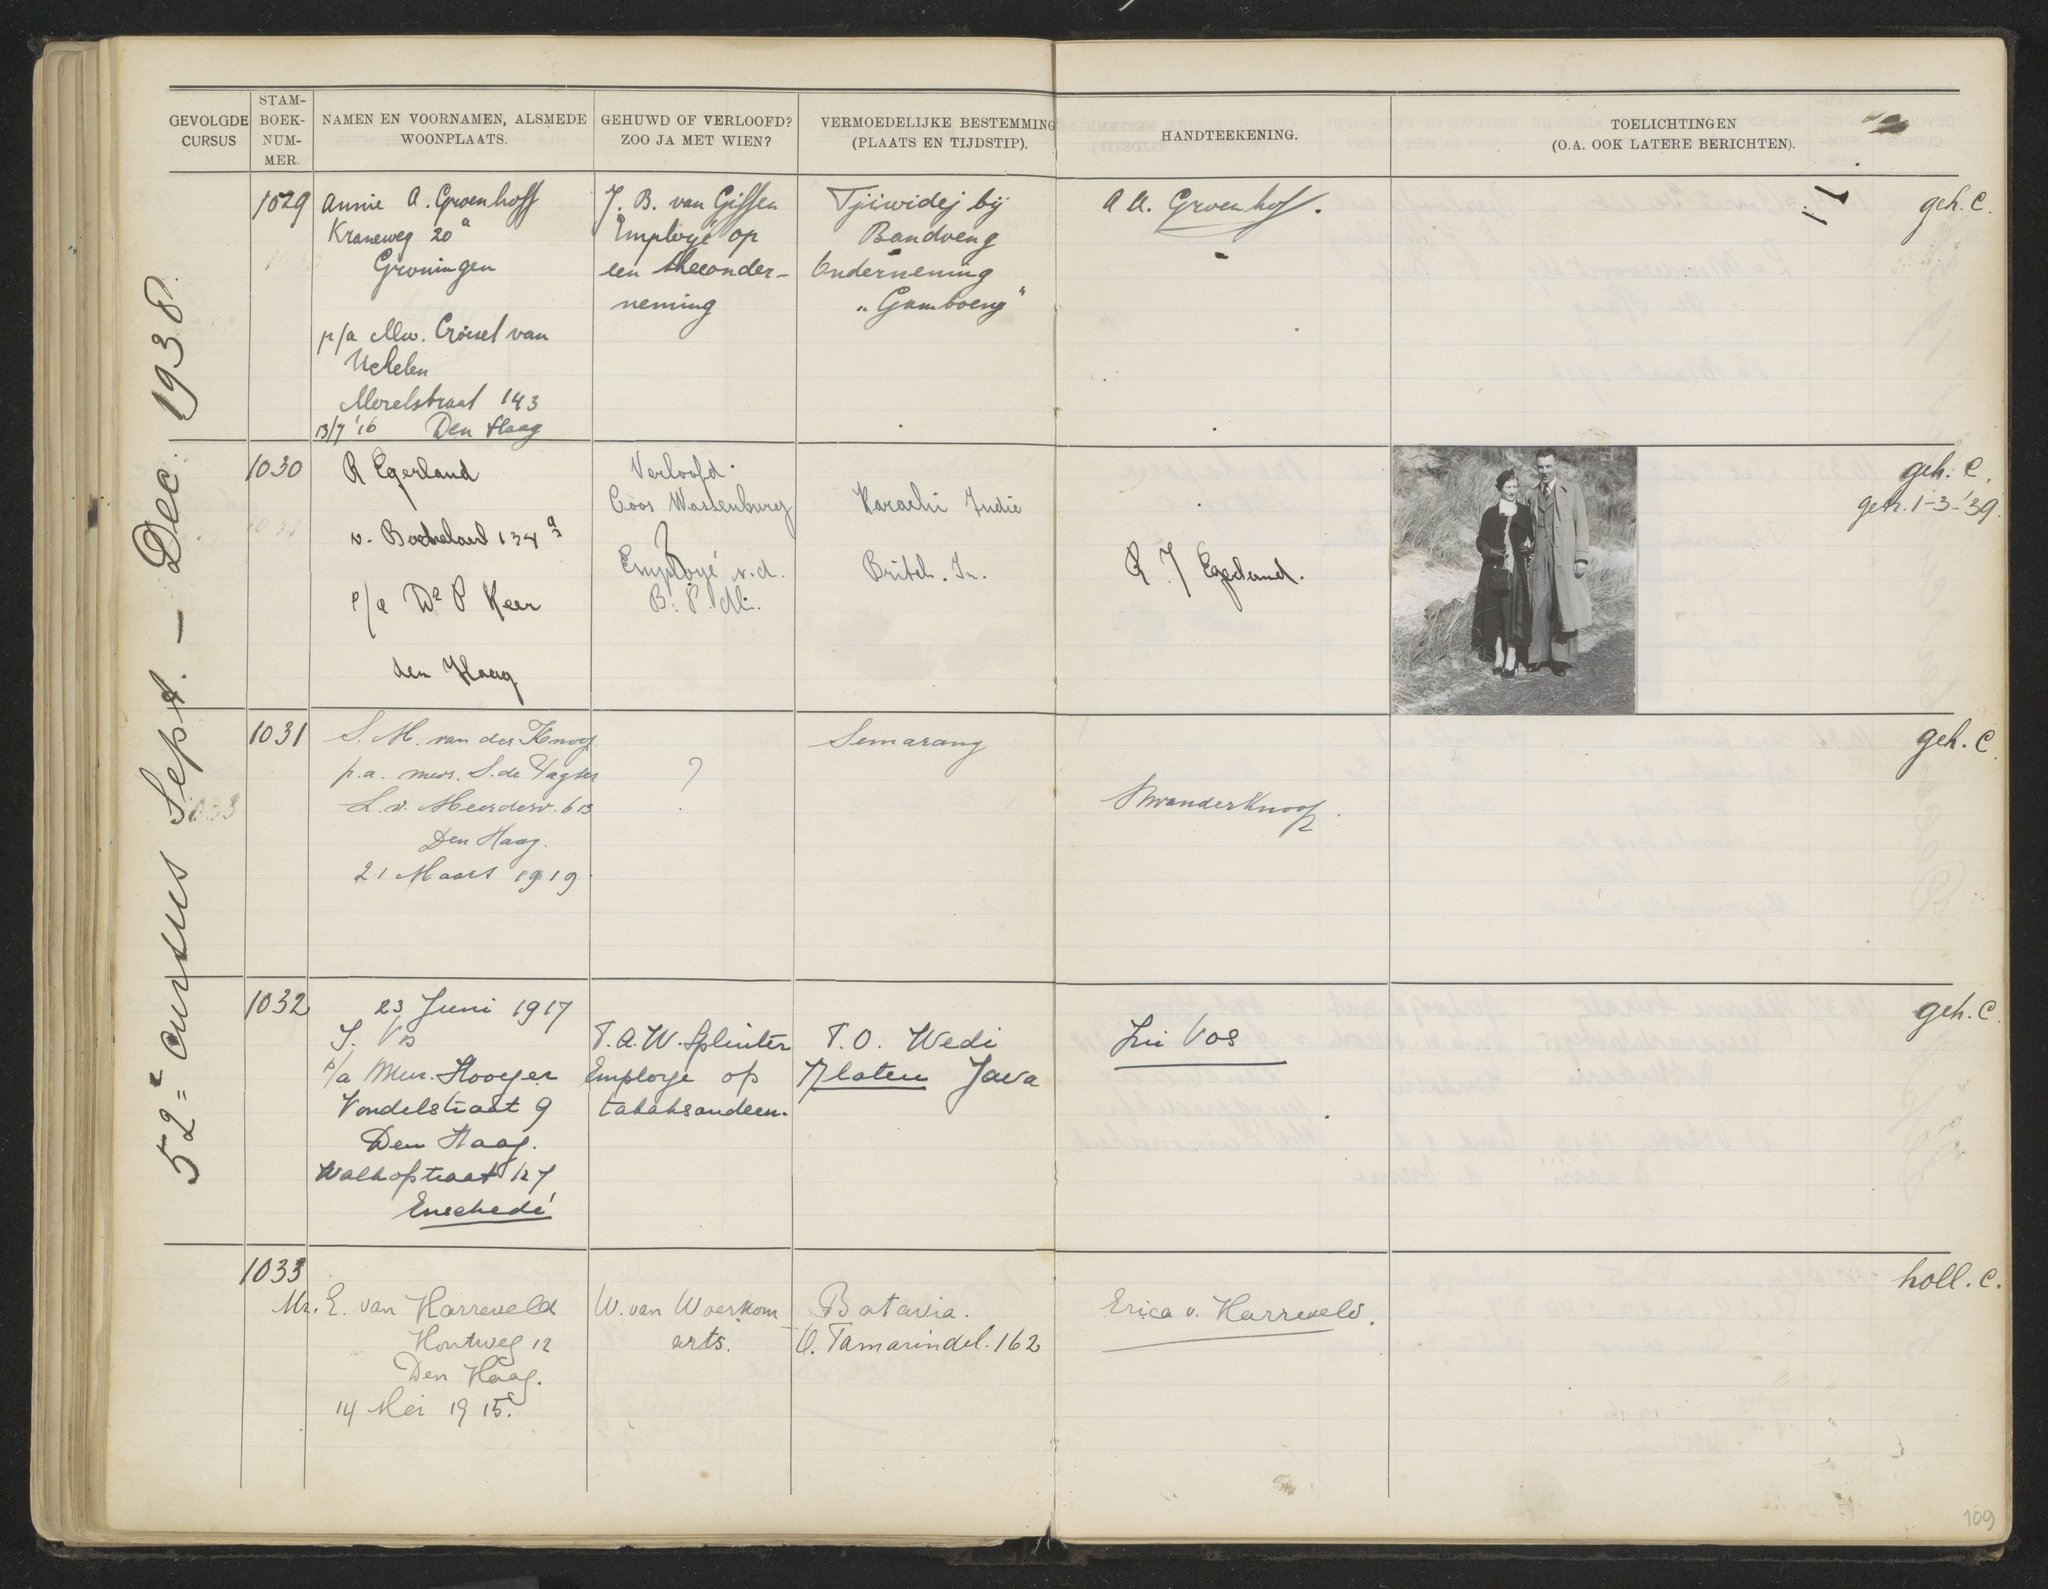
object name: album leaf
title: Blad 109 uit Stamboek van de leerlingen der Koloniale School voor Meisjes en Vrouwen te 's-Gravenhage deel II (1930-1949)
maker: Anonymous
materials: paper, photographic support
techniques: photography, printing, writing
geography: the hague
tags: further education (+ pupil), further education, the hague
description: Twee pagina's met gegevens van de deelnemers aan de 52e driemaandelijkse cursus van september tot december 1938, stamboeknummers 1029 tot en met 1033. Onderdeel van Stamboek van de leerlingen der Koloniale School voor Meisjes en Vrouwen te 's-Gravenhage deel II (1930-1949).